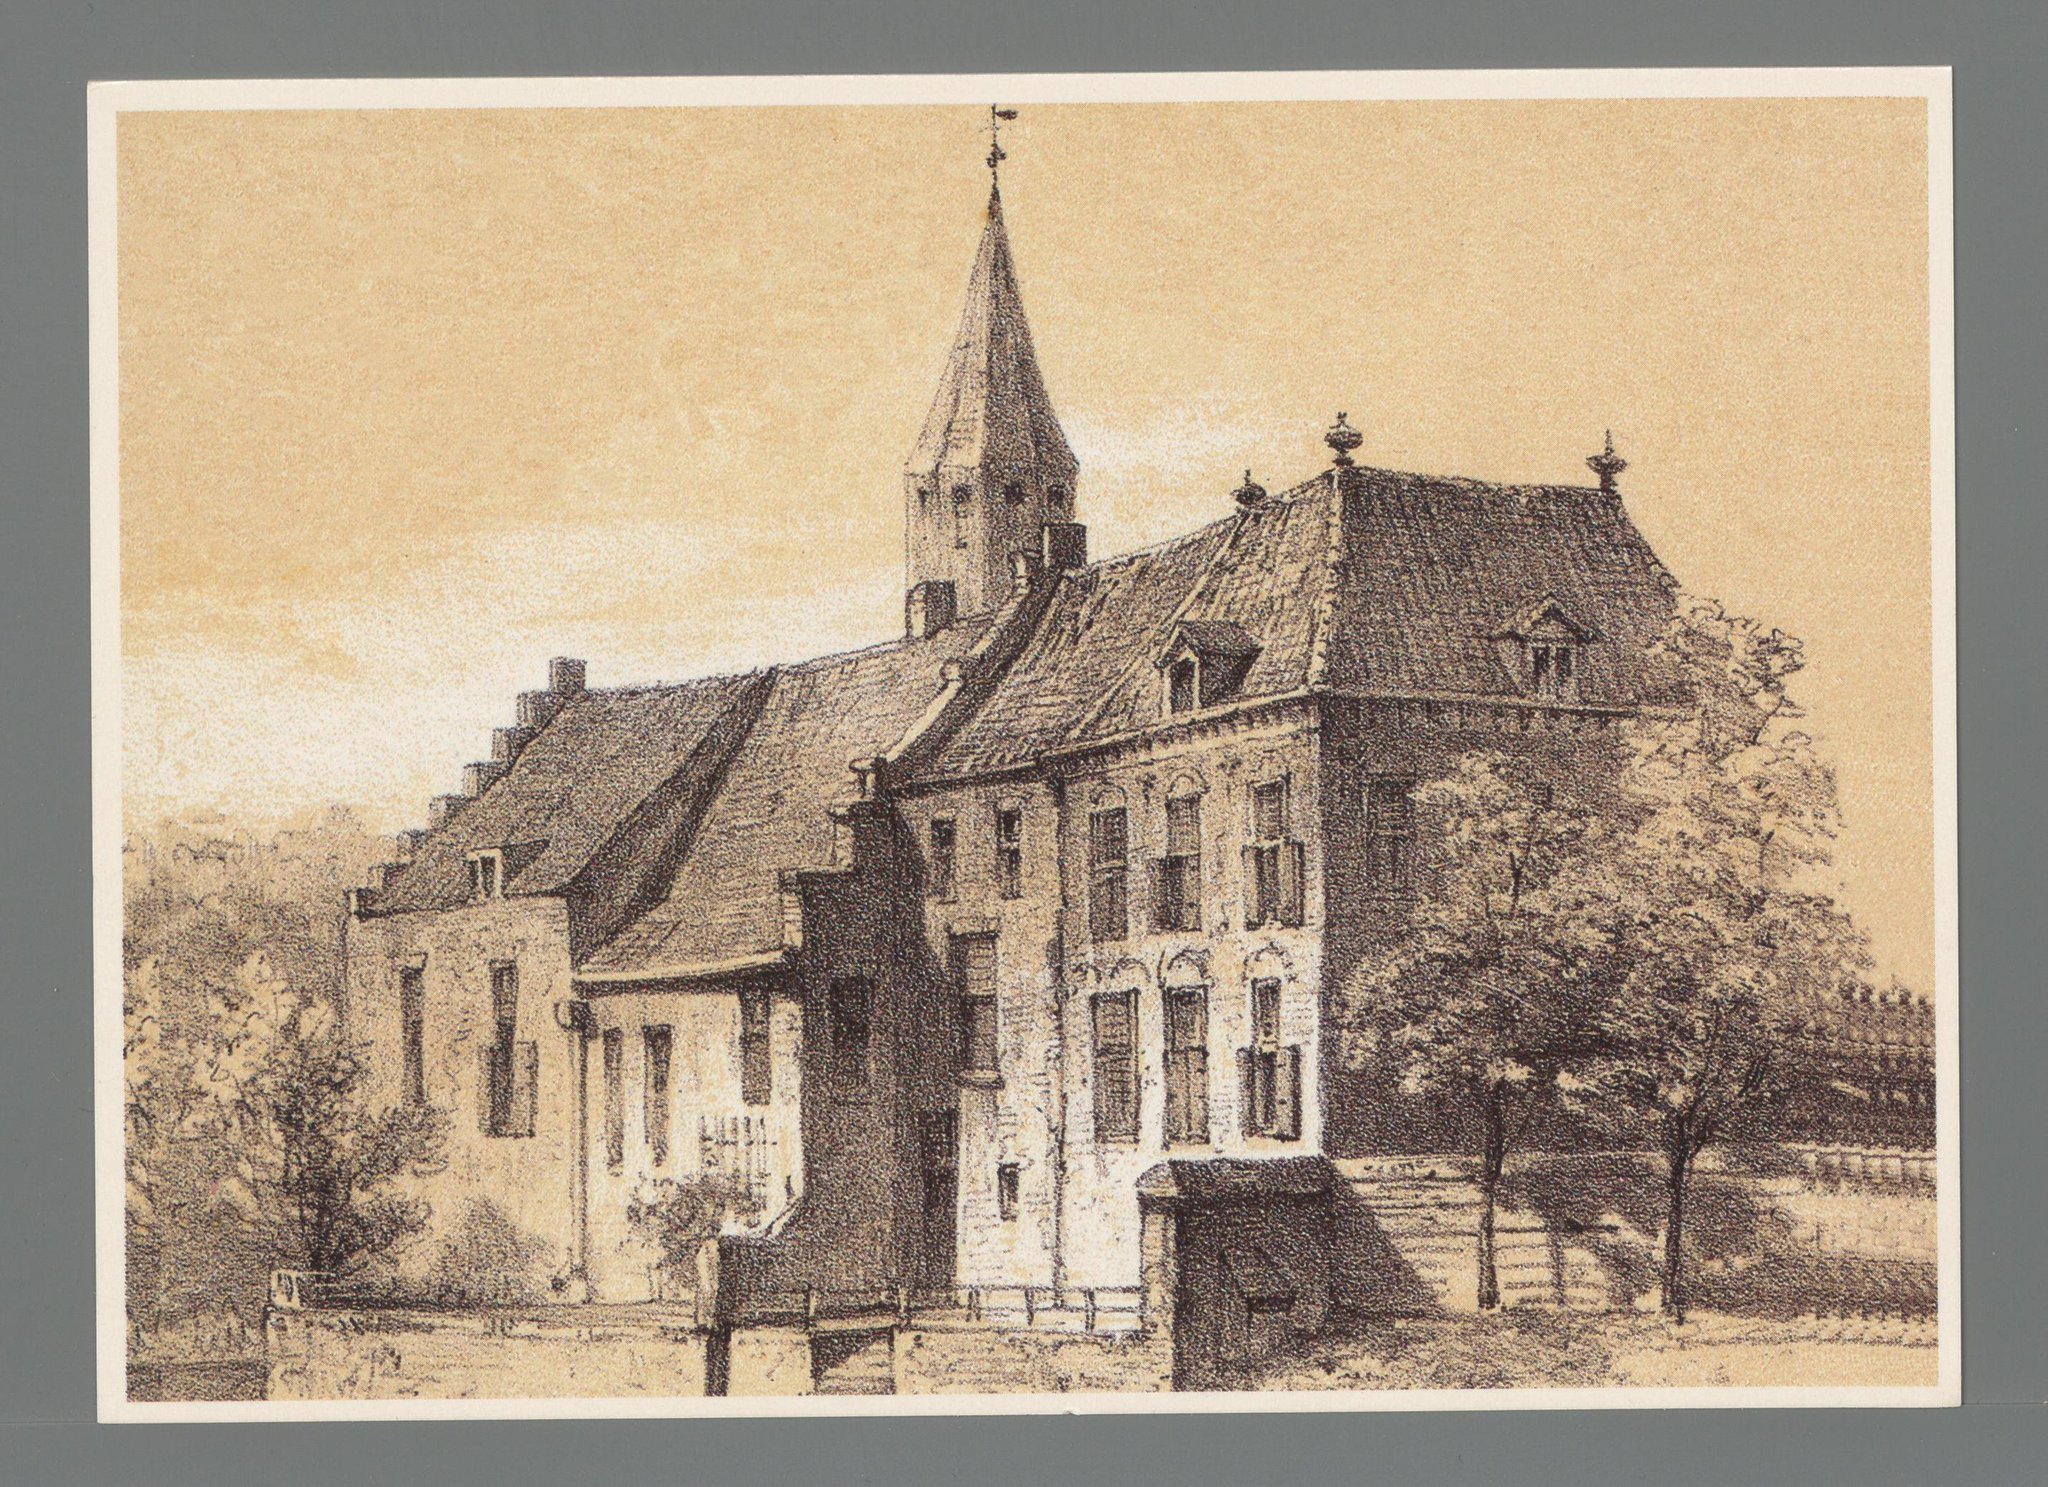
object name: ansichtkaart, prentbriefkaart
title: Wiardastate bij Goutum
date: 1998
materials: cardboard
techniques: offset printed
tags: castle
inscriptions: date